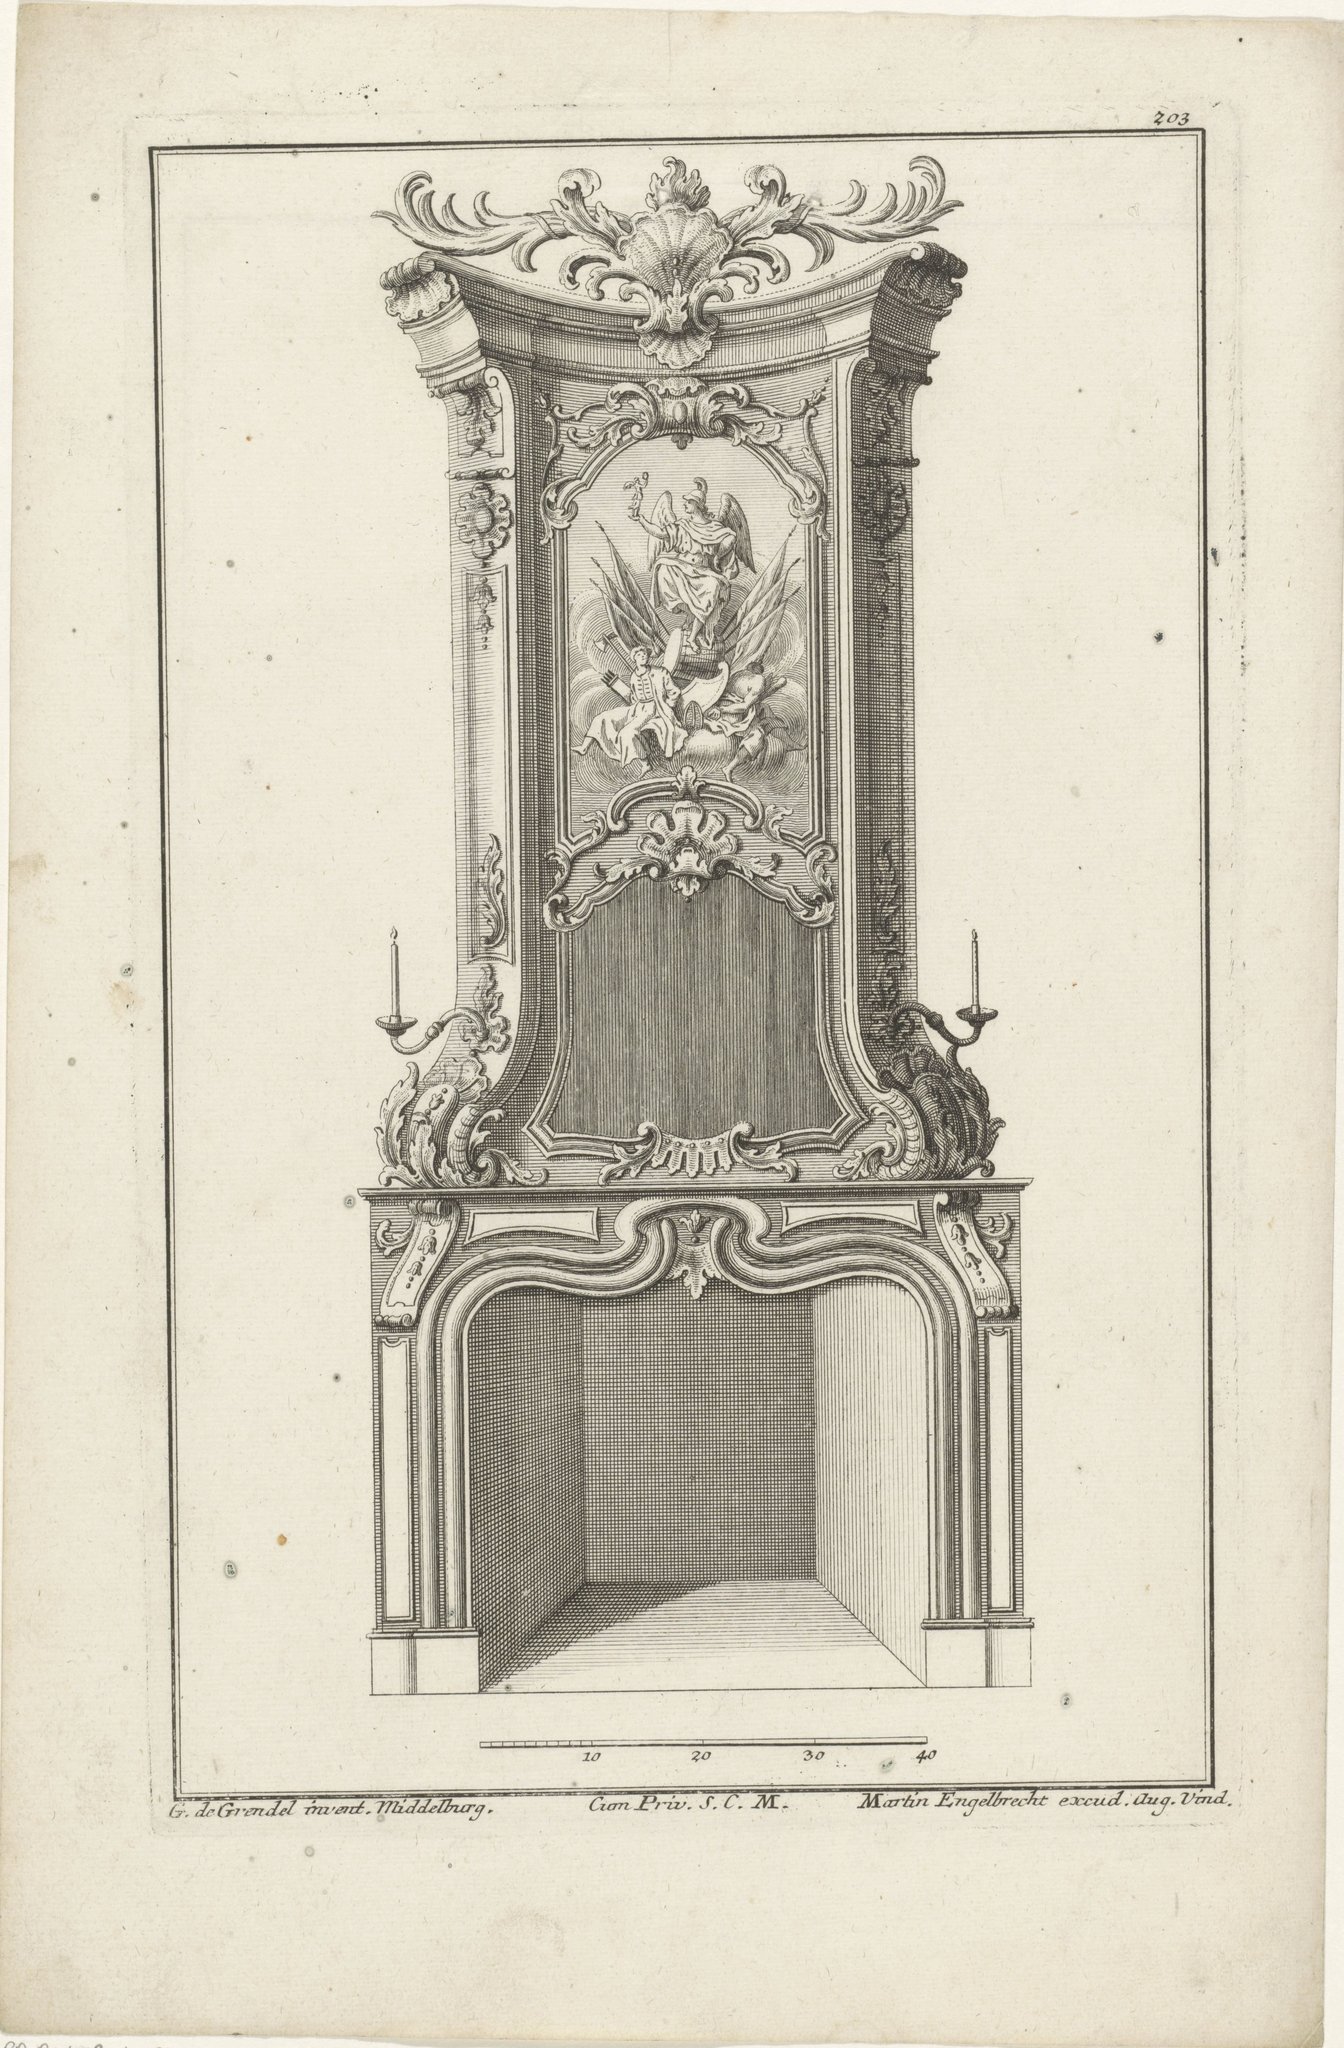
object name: ornament print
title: Neü inventierte Camine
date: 1708-1756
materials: paper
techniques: engraving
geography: middelburg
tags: chimney, ornaments ~ art, 'victoria'; 'vittoria', 'vittoria navale', 'vittoria degl'antichi' (ripa)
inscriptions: collector's mark: Lugt 2228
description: Ontwerp voor een schoorsteen met een voorstelling van Victoria, de gevleugelde overwinning, die troont op een trommel, wapentuig en krijgsgevangenen. De schoorsteenmantel is versierd met bladornamenten. Midden onder een schaalverdeling. Prentnummer 203.